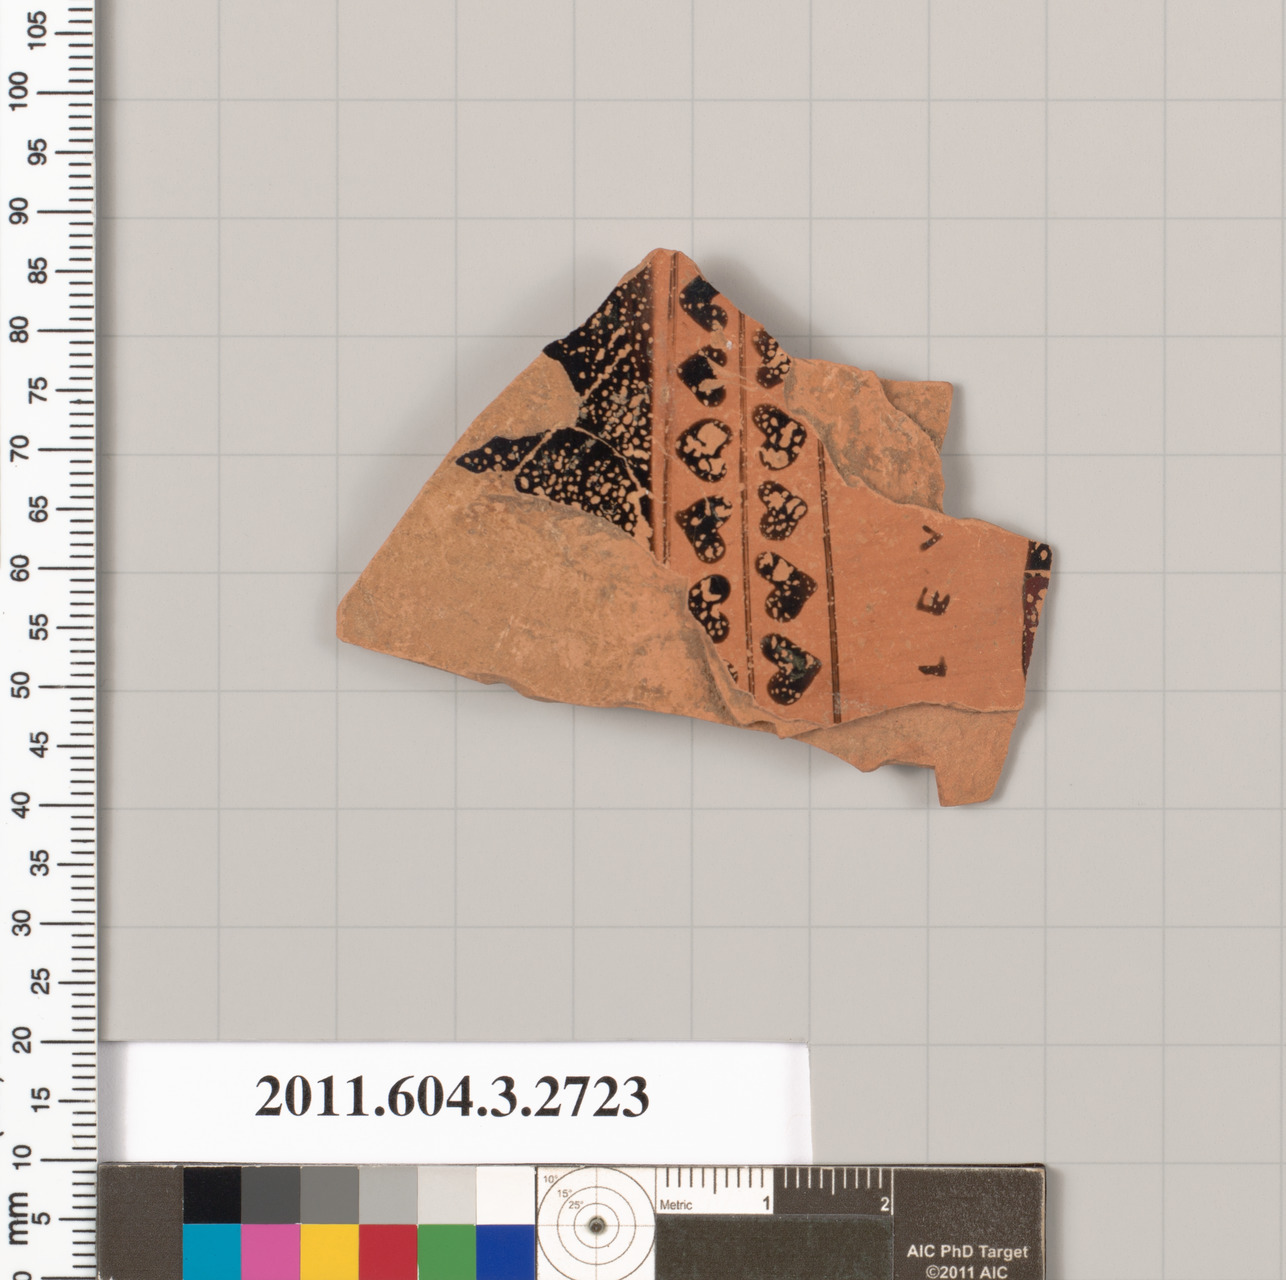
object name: oinochoe fragment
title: Terracotta fragment of an oinochoe (jug)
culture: greek, attic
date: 530-520 BCE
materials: terracotta